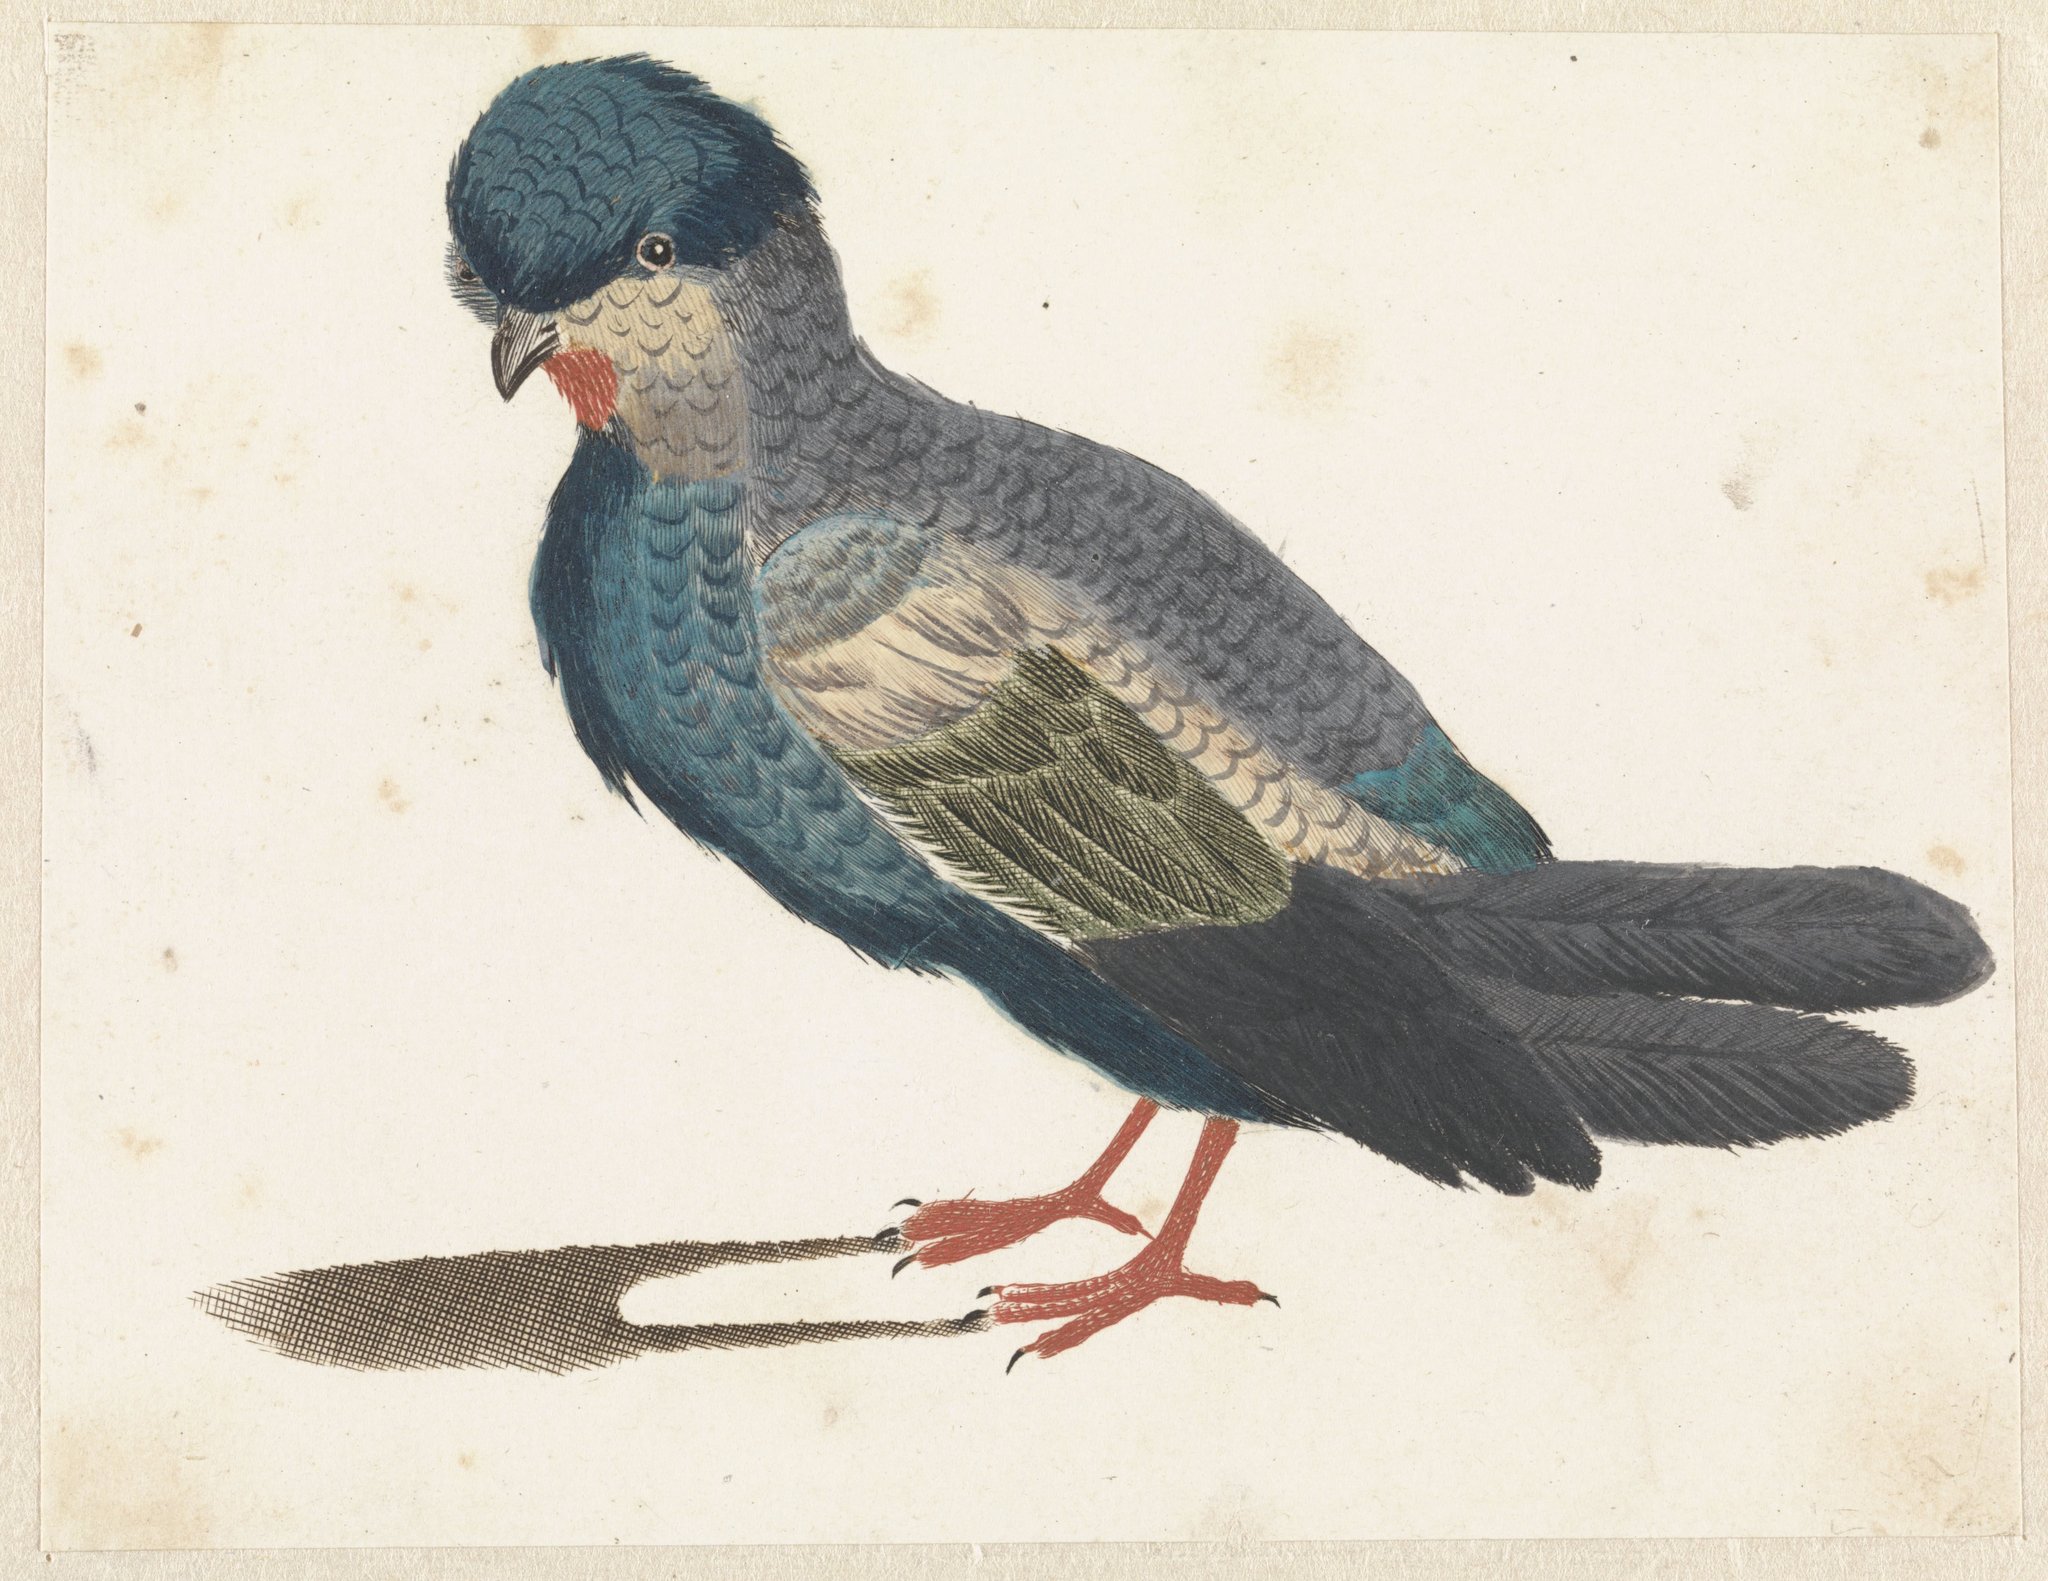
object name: print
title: Staande vogel naar links, mogelijk een duif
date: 1688-1698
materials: paper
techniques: printing, engraving, hand coloring, lithography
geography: netherlands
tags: birds, doves, pigeons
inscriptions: collector's mark: Lugt 2228